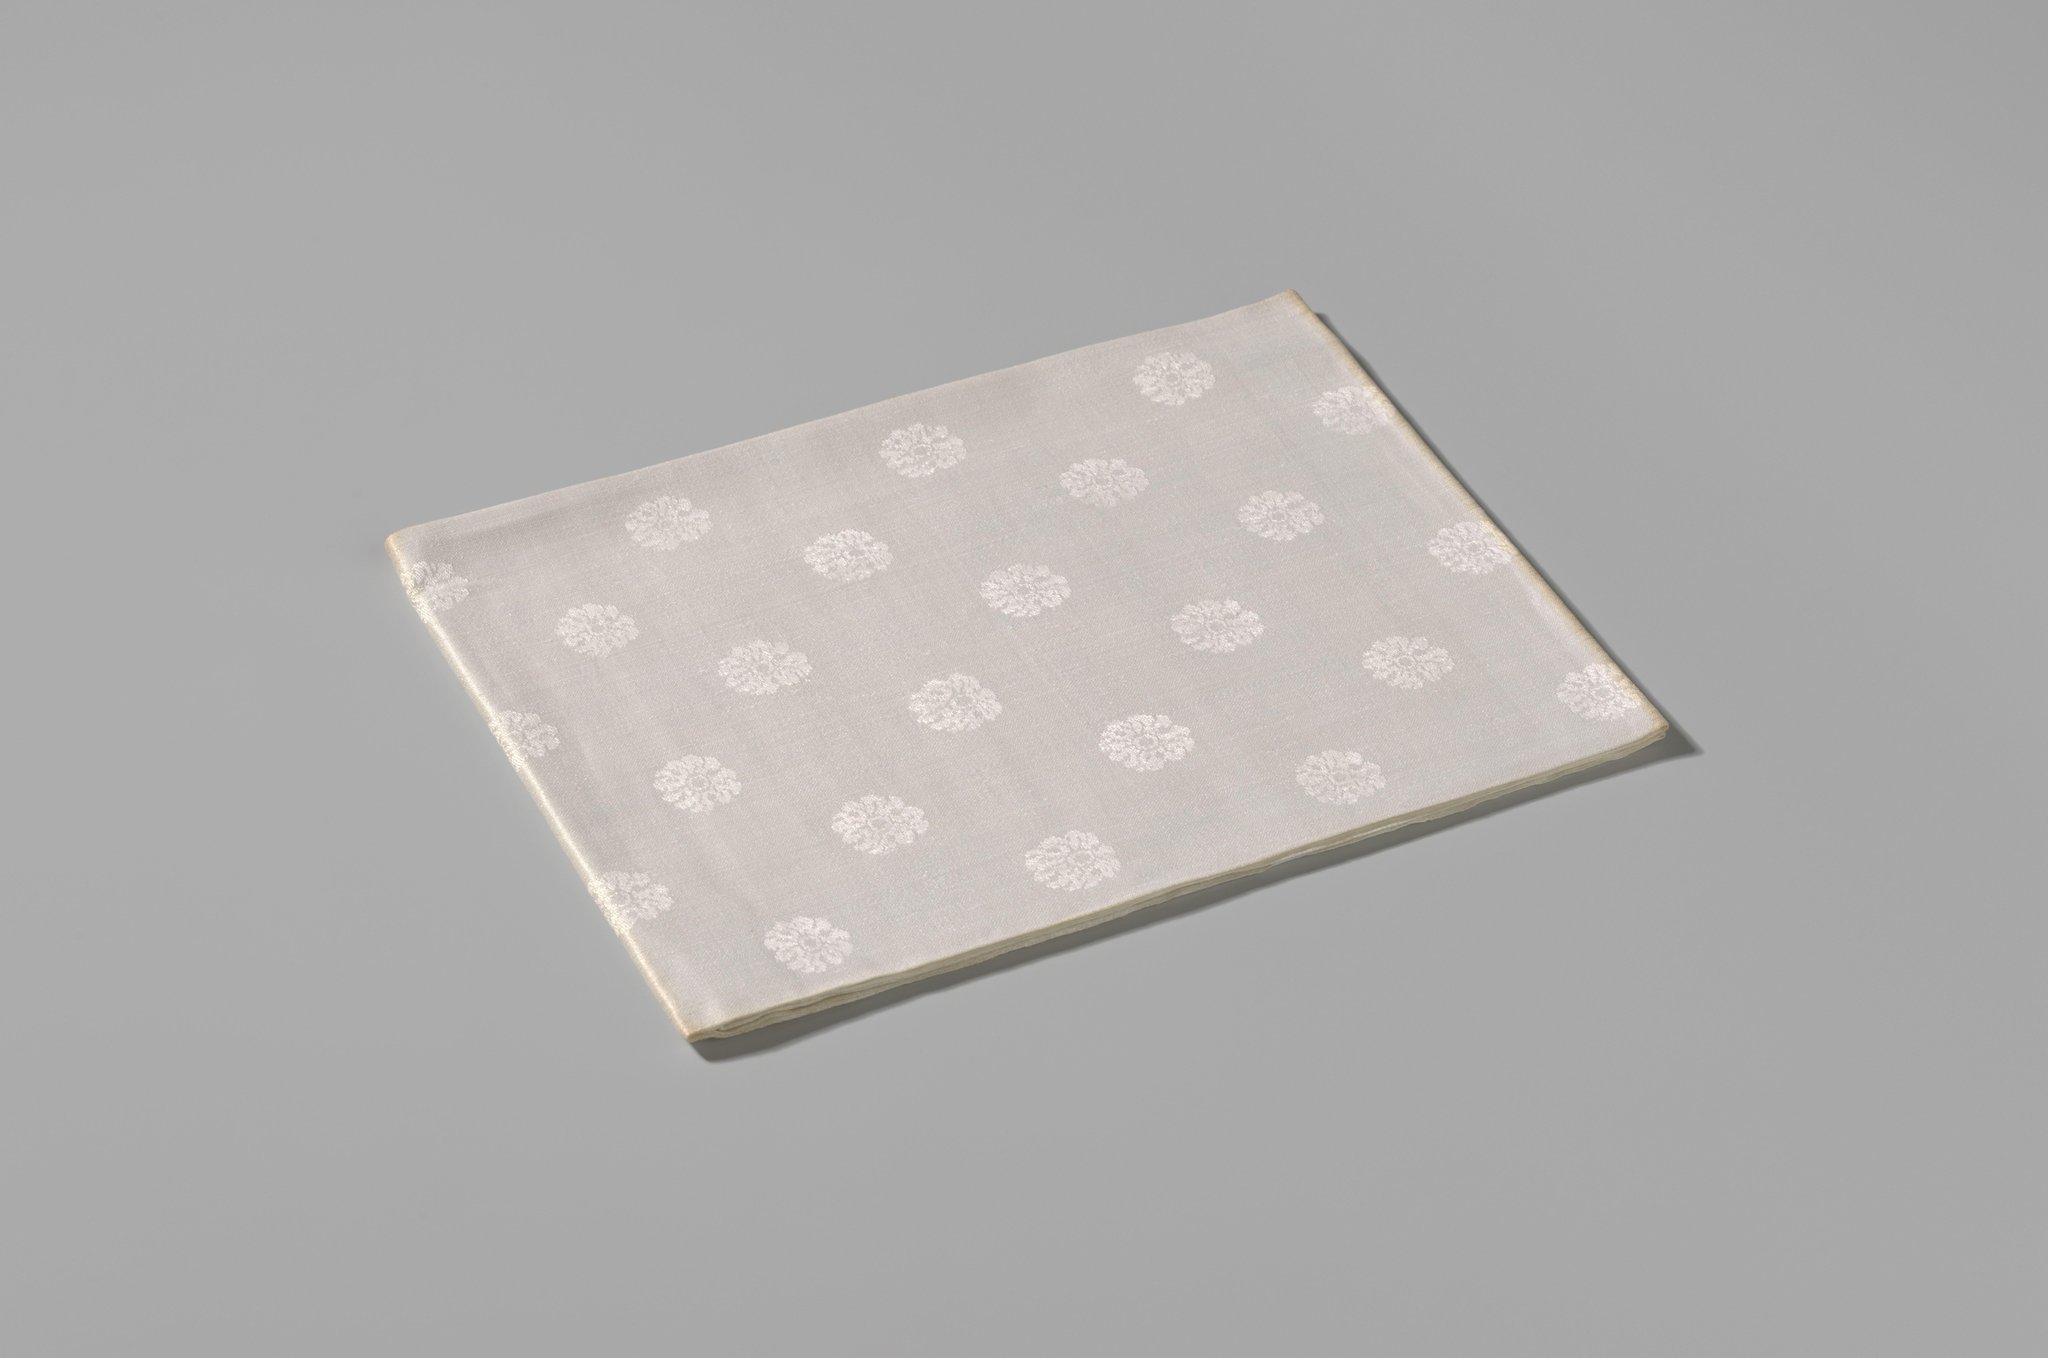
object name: napkin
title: Servet met patroon van rozetten en rozentakken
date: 1780-1800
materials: linen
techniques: damask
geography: northern netherlands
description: Wit linnendamasten servet met een patroon van rozetten en rozentakken, merk 100 en HW 30.